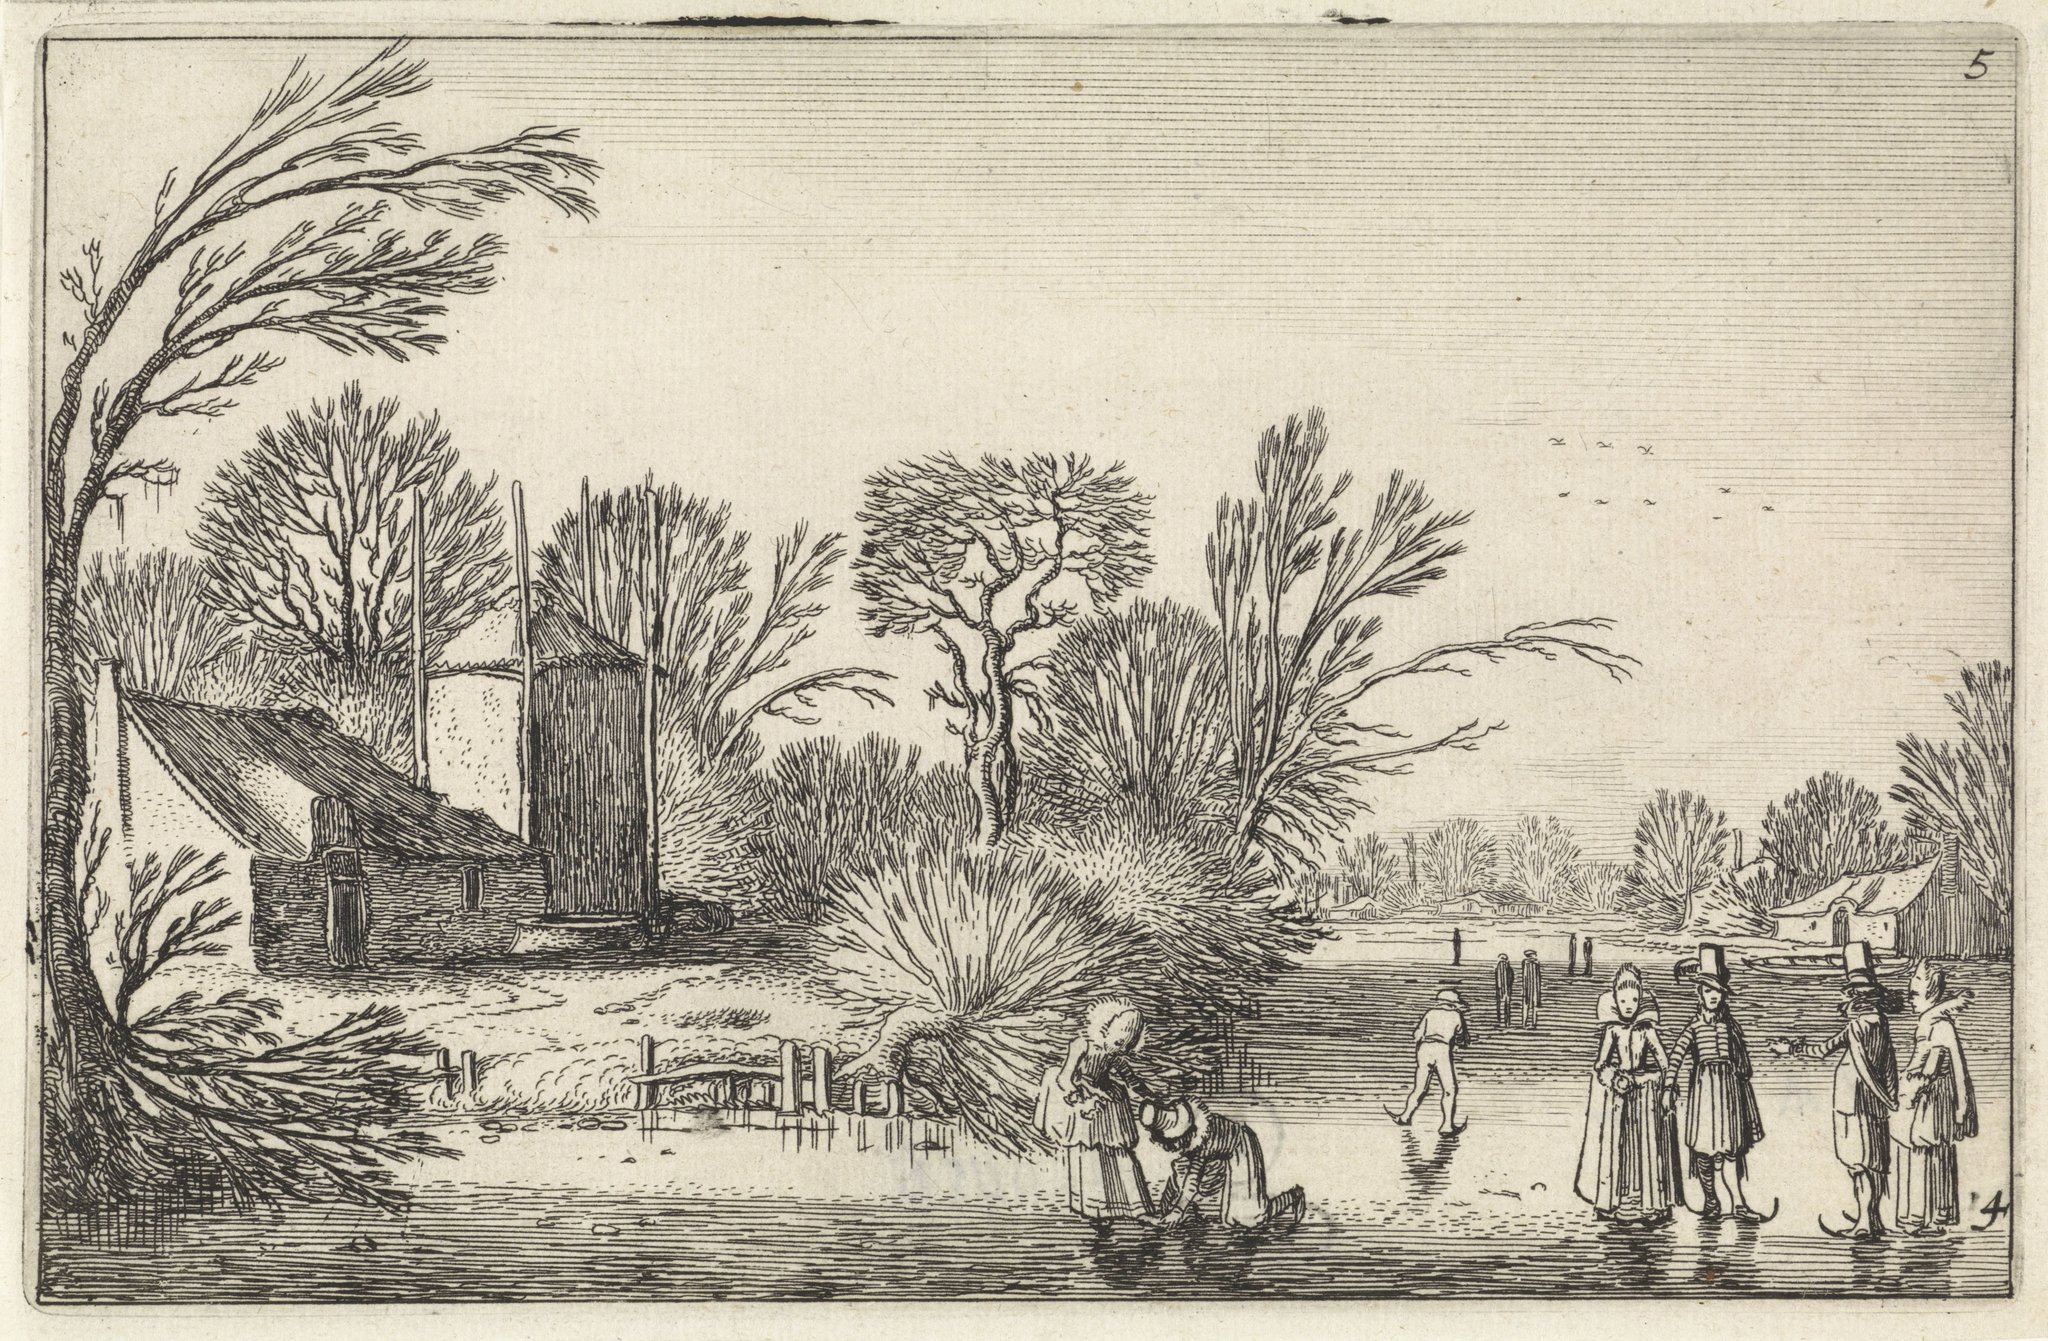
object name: print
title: Amenissimae aliquot requculae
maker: jan van de velde (ii)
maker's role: draughtsman, painter, print maker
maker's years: 1593-1641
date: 1616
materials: paper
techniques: etching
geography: northern netherlands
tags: skates (winter sports), hay-stack, farm (building)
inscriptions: collector's mark: Lugt 964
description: Schaatsers op het ijs bij een boerderij met een hooiberg. Vierde prent van deel vijf van een serie van in totaal zestig prenten met landschappen, verdeeld over vijf delen van elk twaalf prenten.